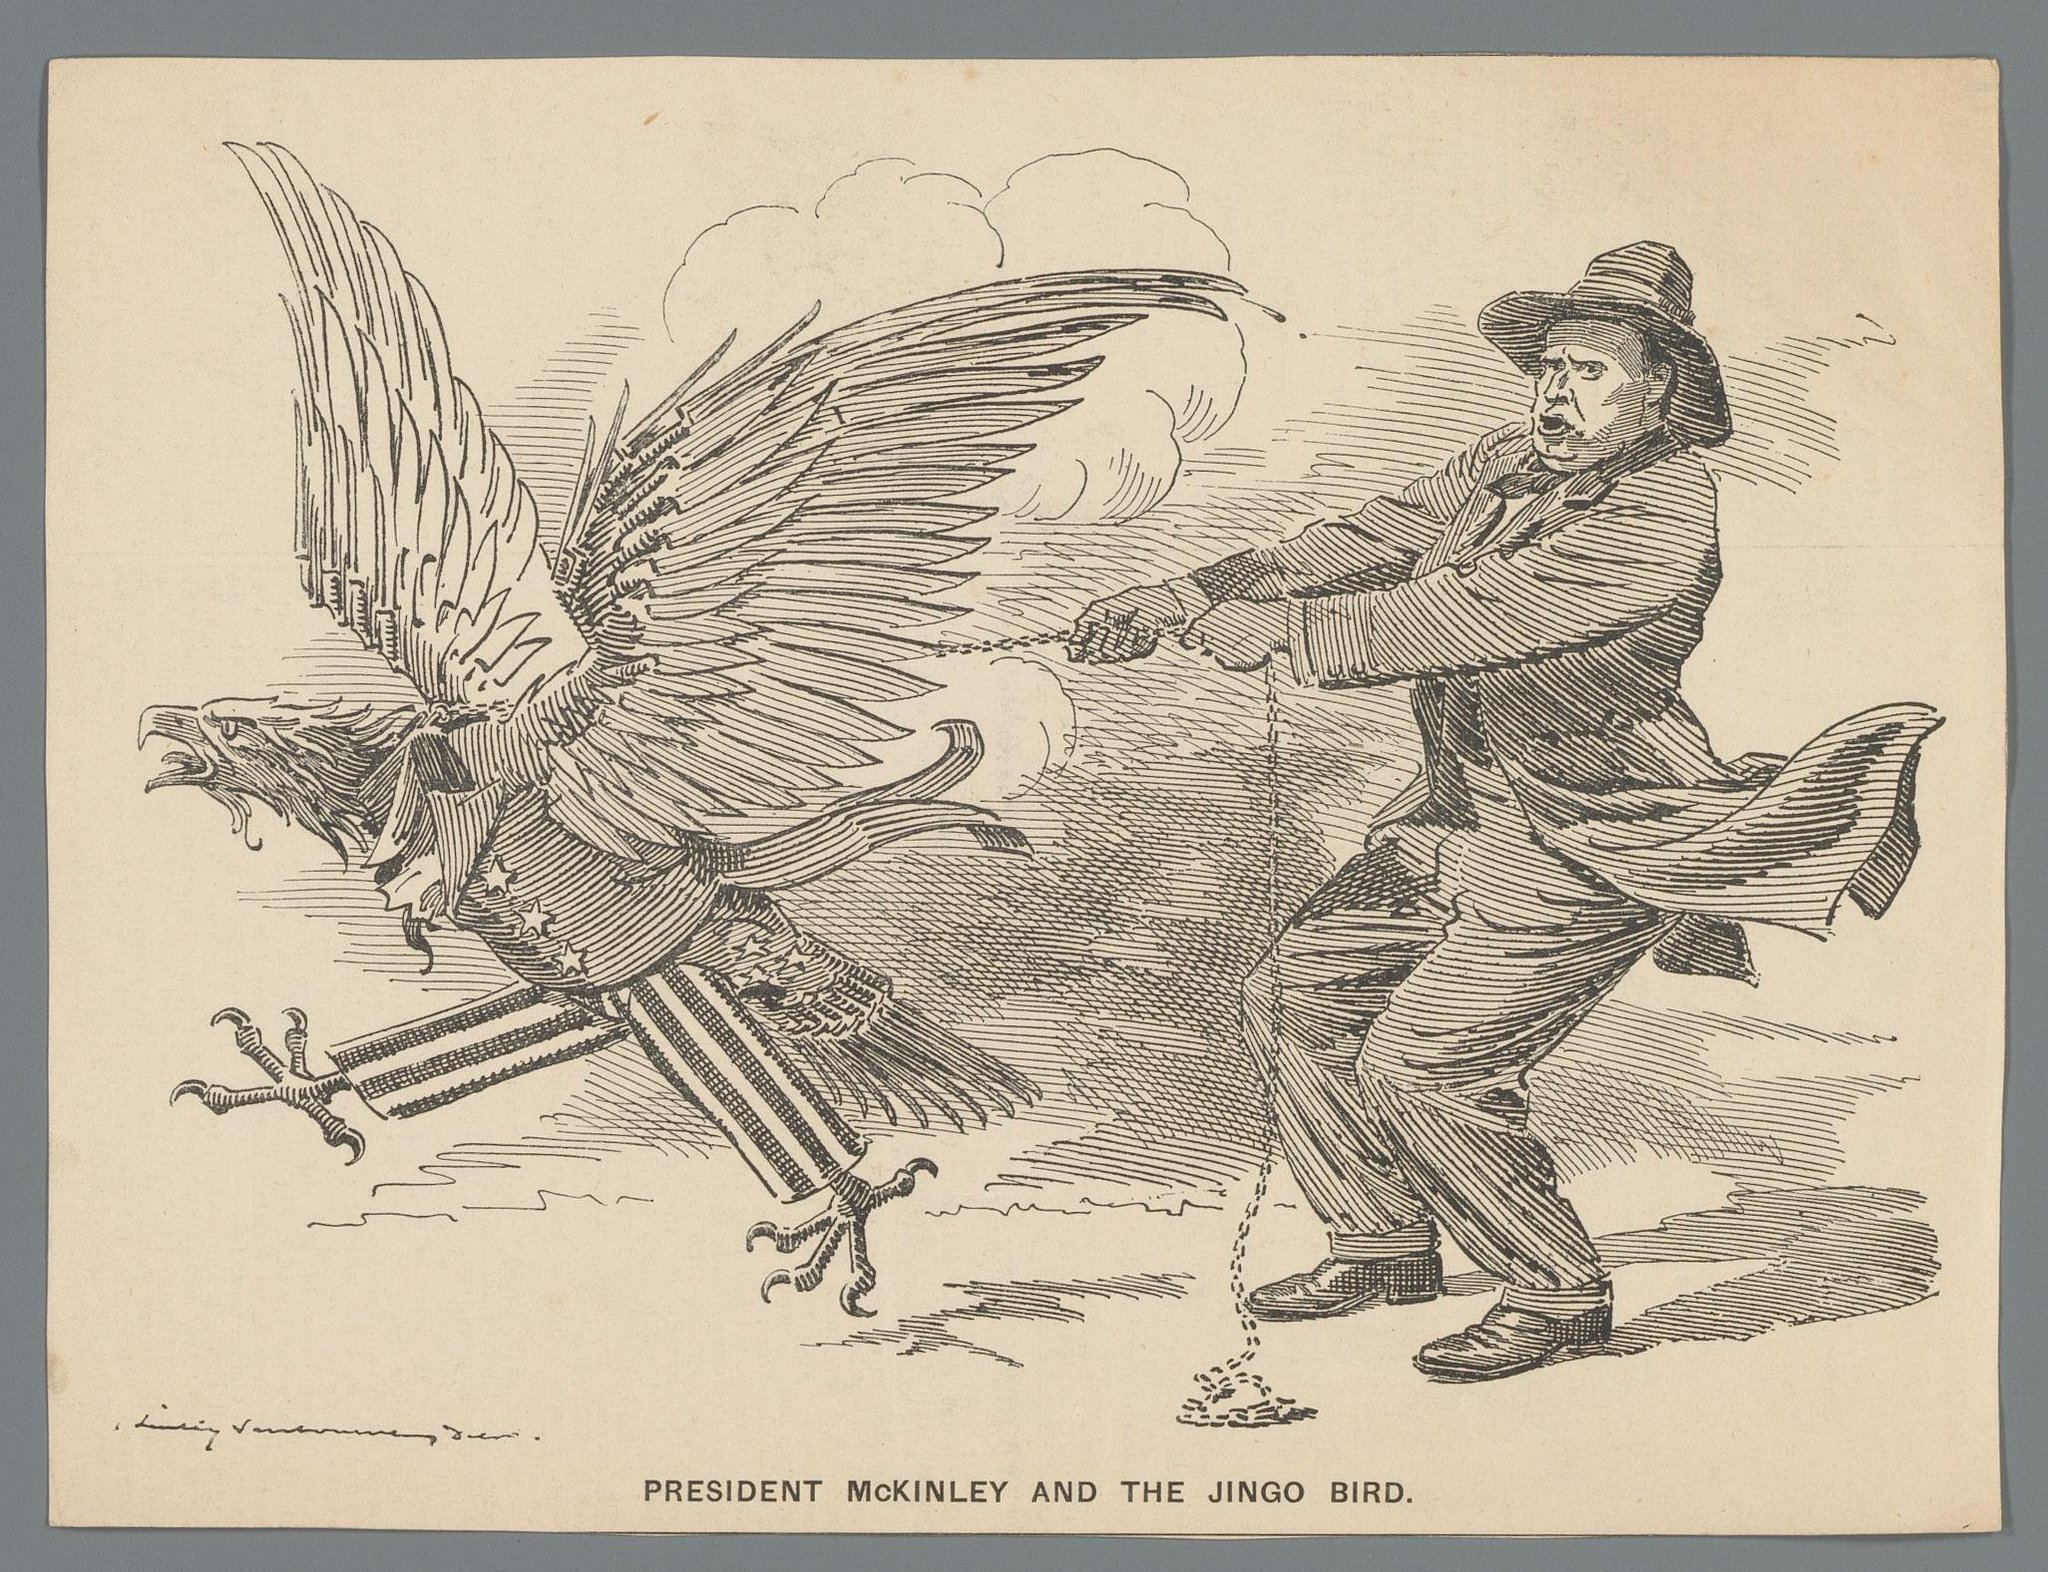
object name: print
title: President McKinley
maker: edward linley sambourne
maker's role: draughtsman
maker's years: 1844-1910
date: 1897-1901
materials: paper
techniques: line block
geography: england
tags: predatory birds: eagle, political caricatures and satires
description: De Amerikaanse president McKinley probeert een Amerikaanse adelaar in toom te houden. Spotprent uit het satirische tijdschrift Punch, ca. 1897-1901.